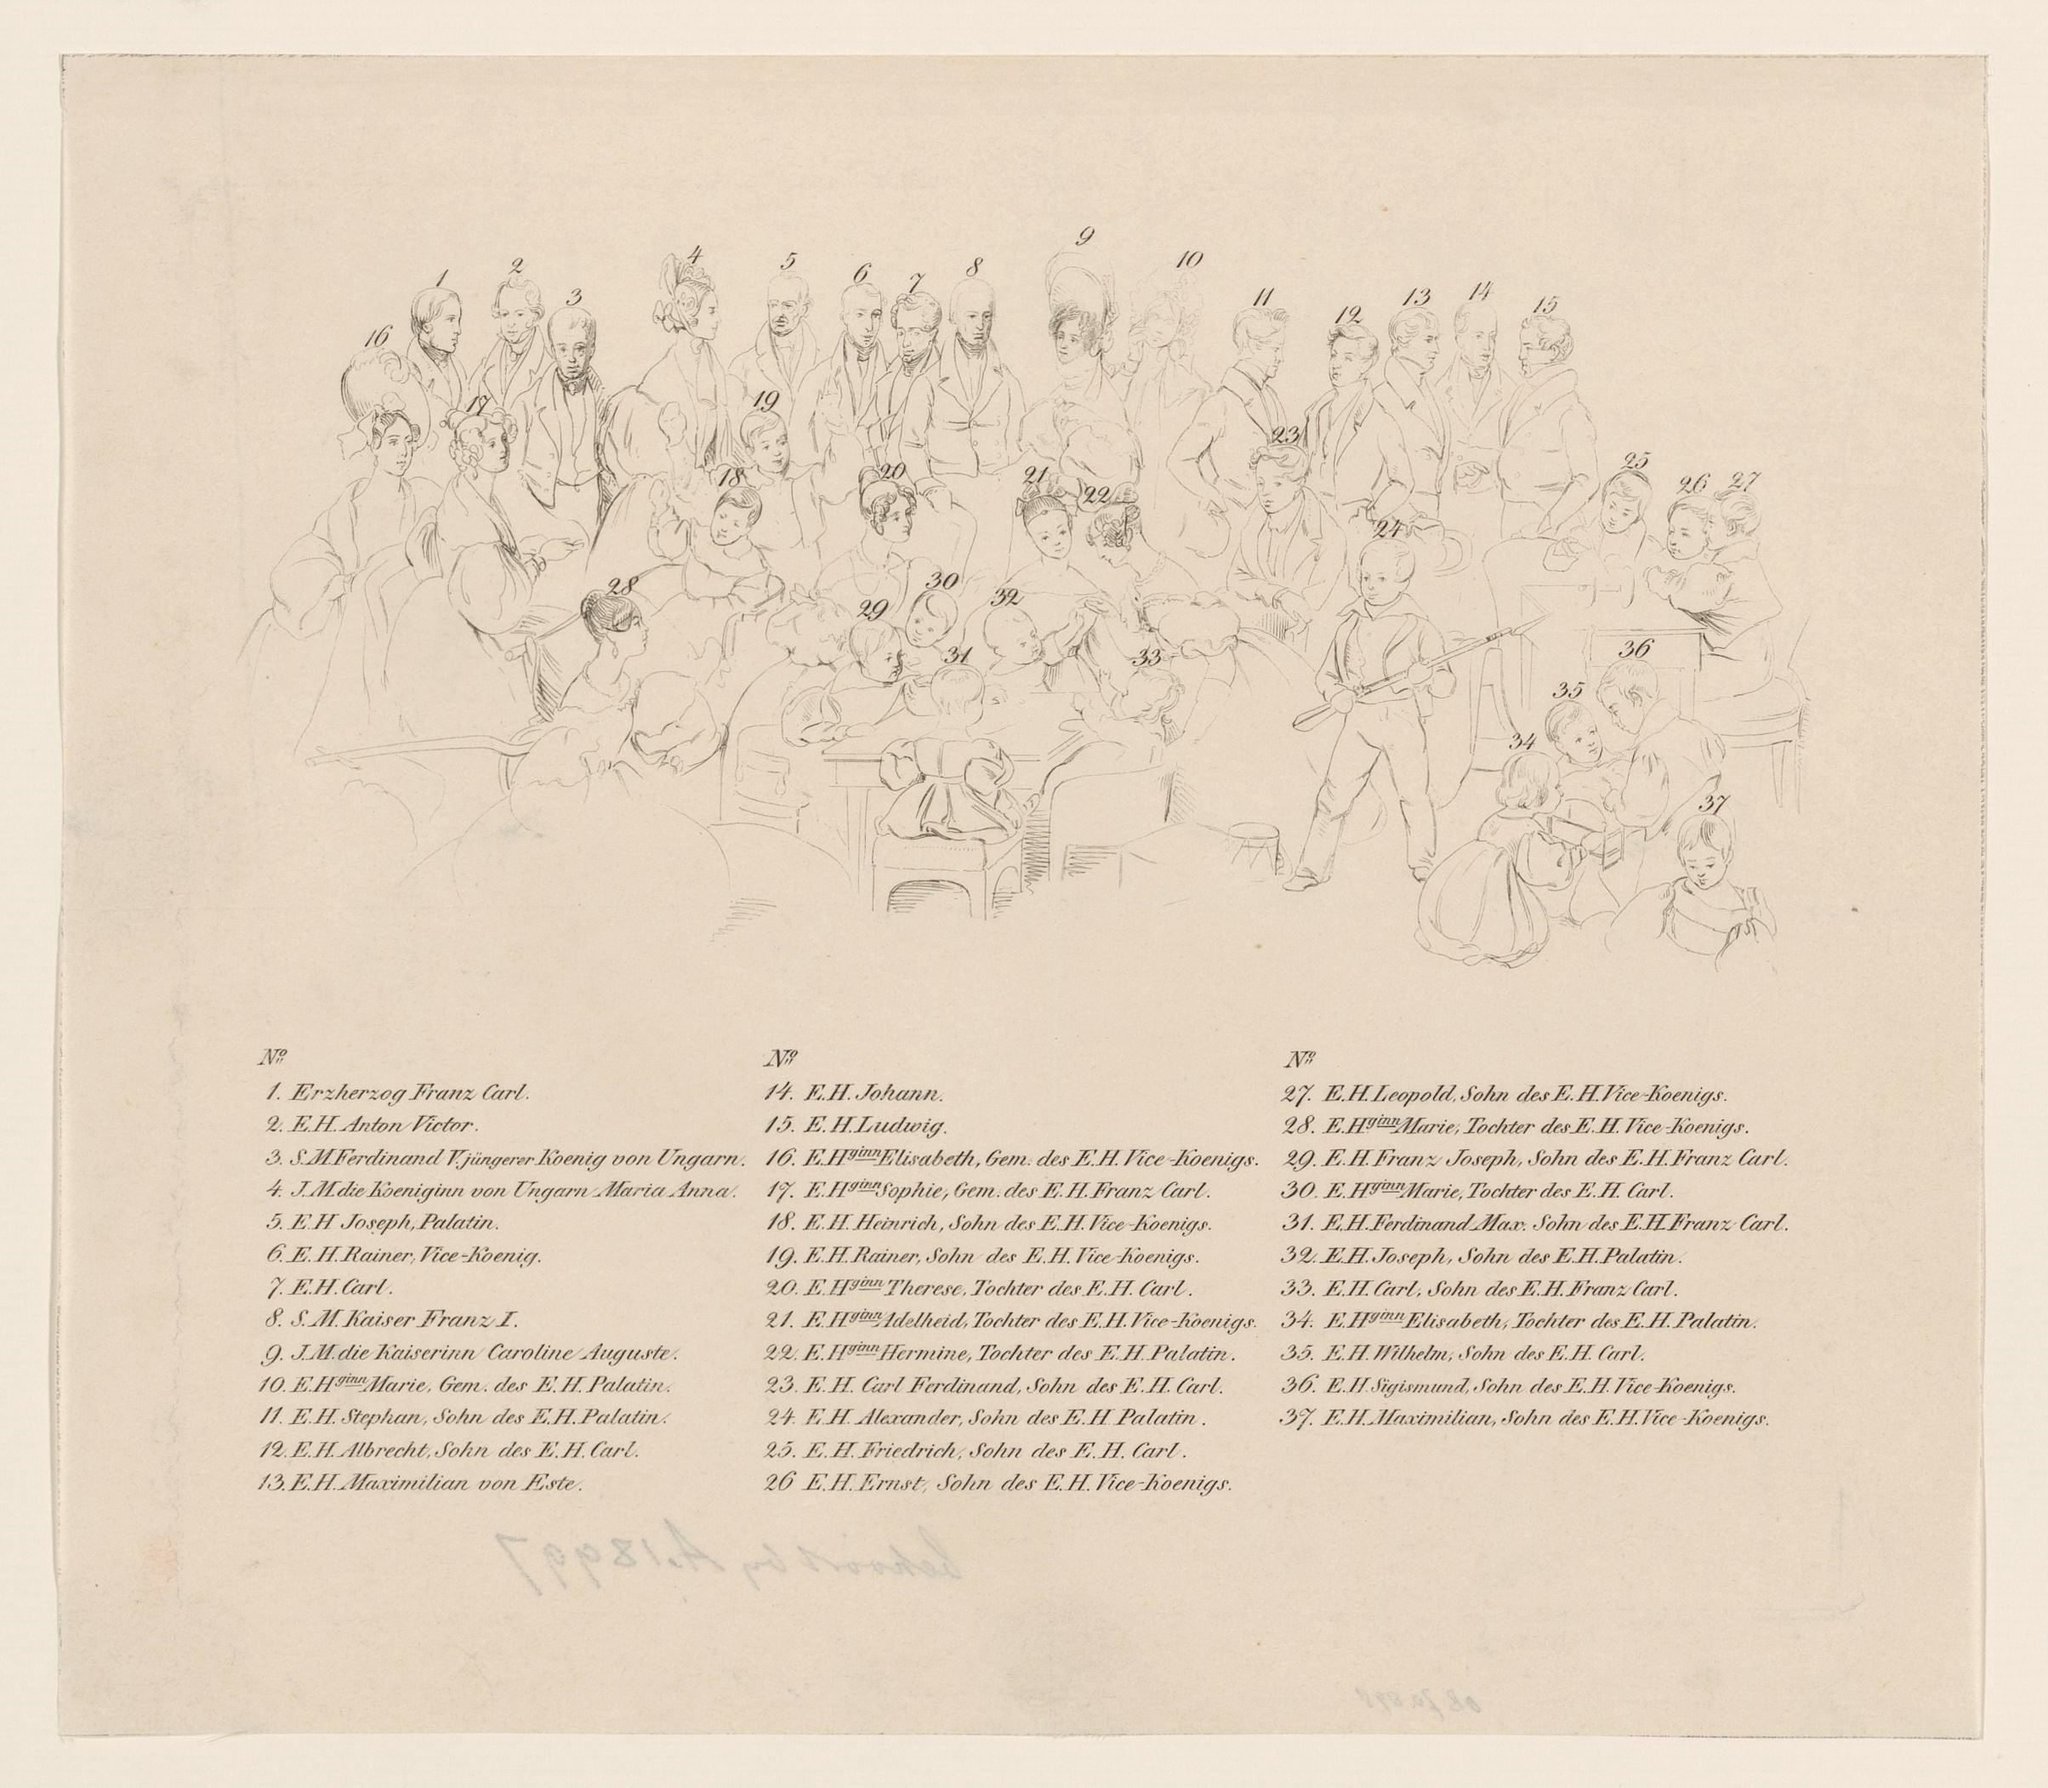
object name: print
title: Sleutel voor de prent: Familiebijeenkomst van de familie van Caroline Augusta van Beieren, keizerin van Oostenrijk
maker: Anonymous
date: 1834-1874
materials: paper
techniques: etching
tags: adult woman, children's games and plays, adult man, family, descendance